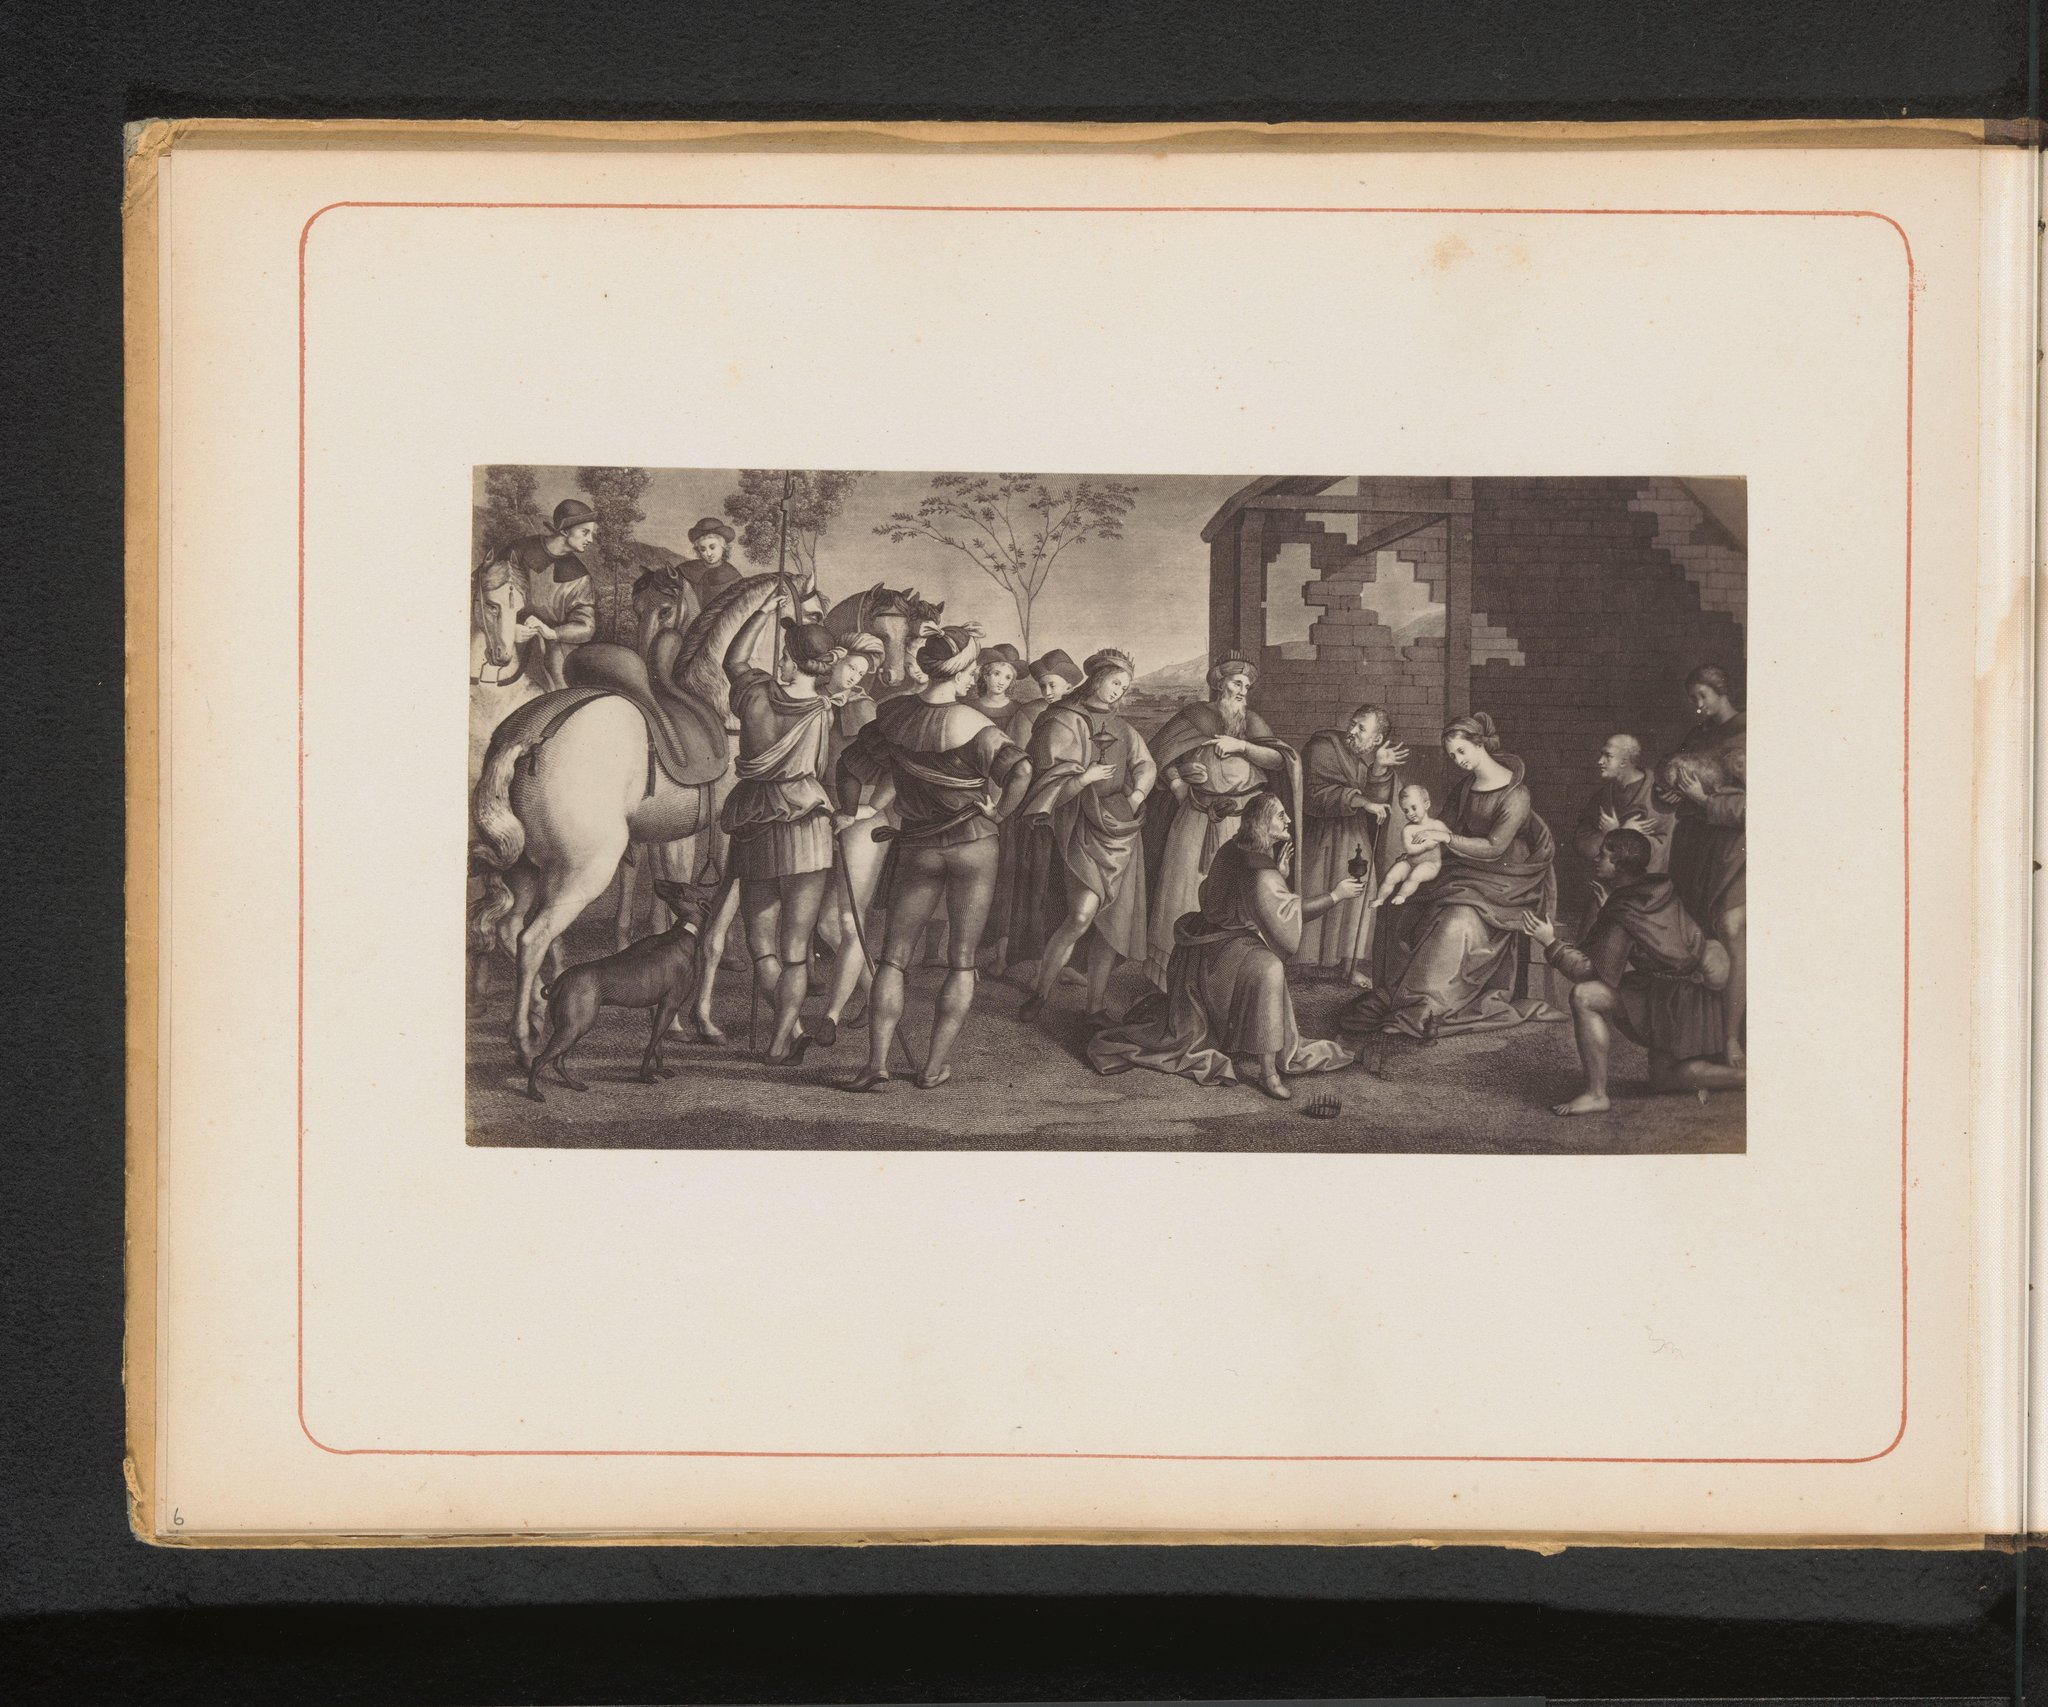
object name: page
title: Fotoreproductie van een gravure naar De aanbidding van de koningen door Rafaël in het Vaticaan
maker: Anonymous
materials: photographic support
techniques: albumen print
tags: adoration of the kings: the wise men present their gifts to the christ-child (gold, frankincense and myrrh)